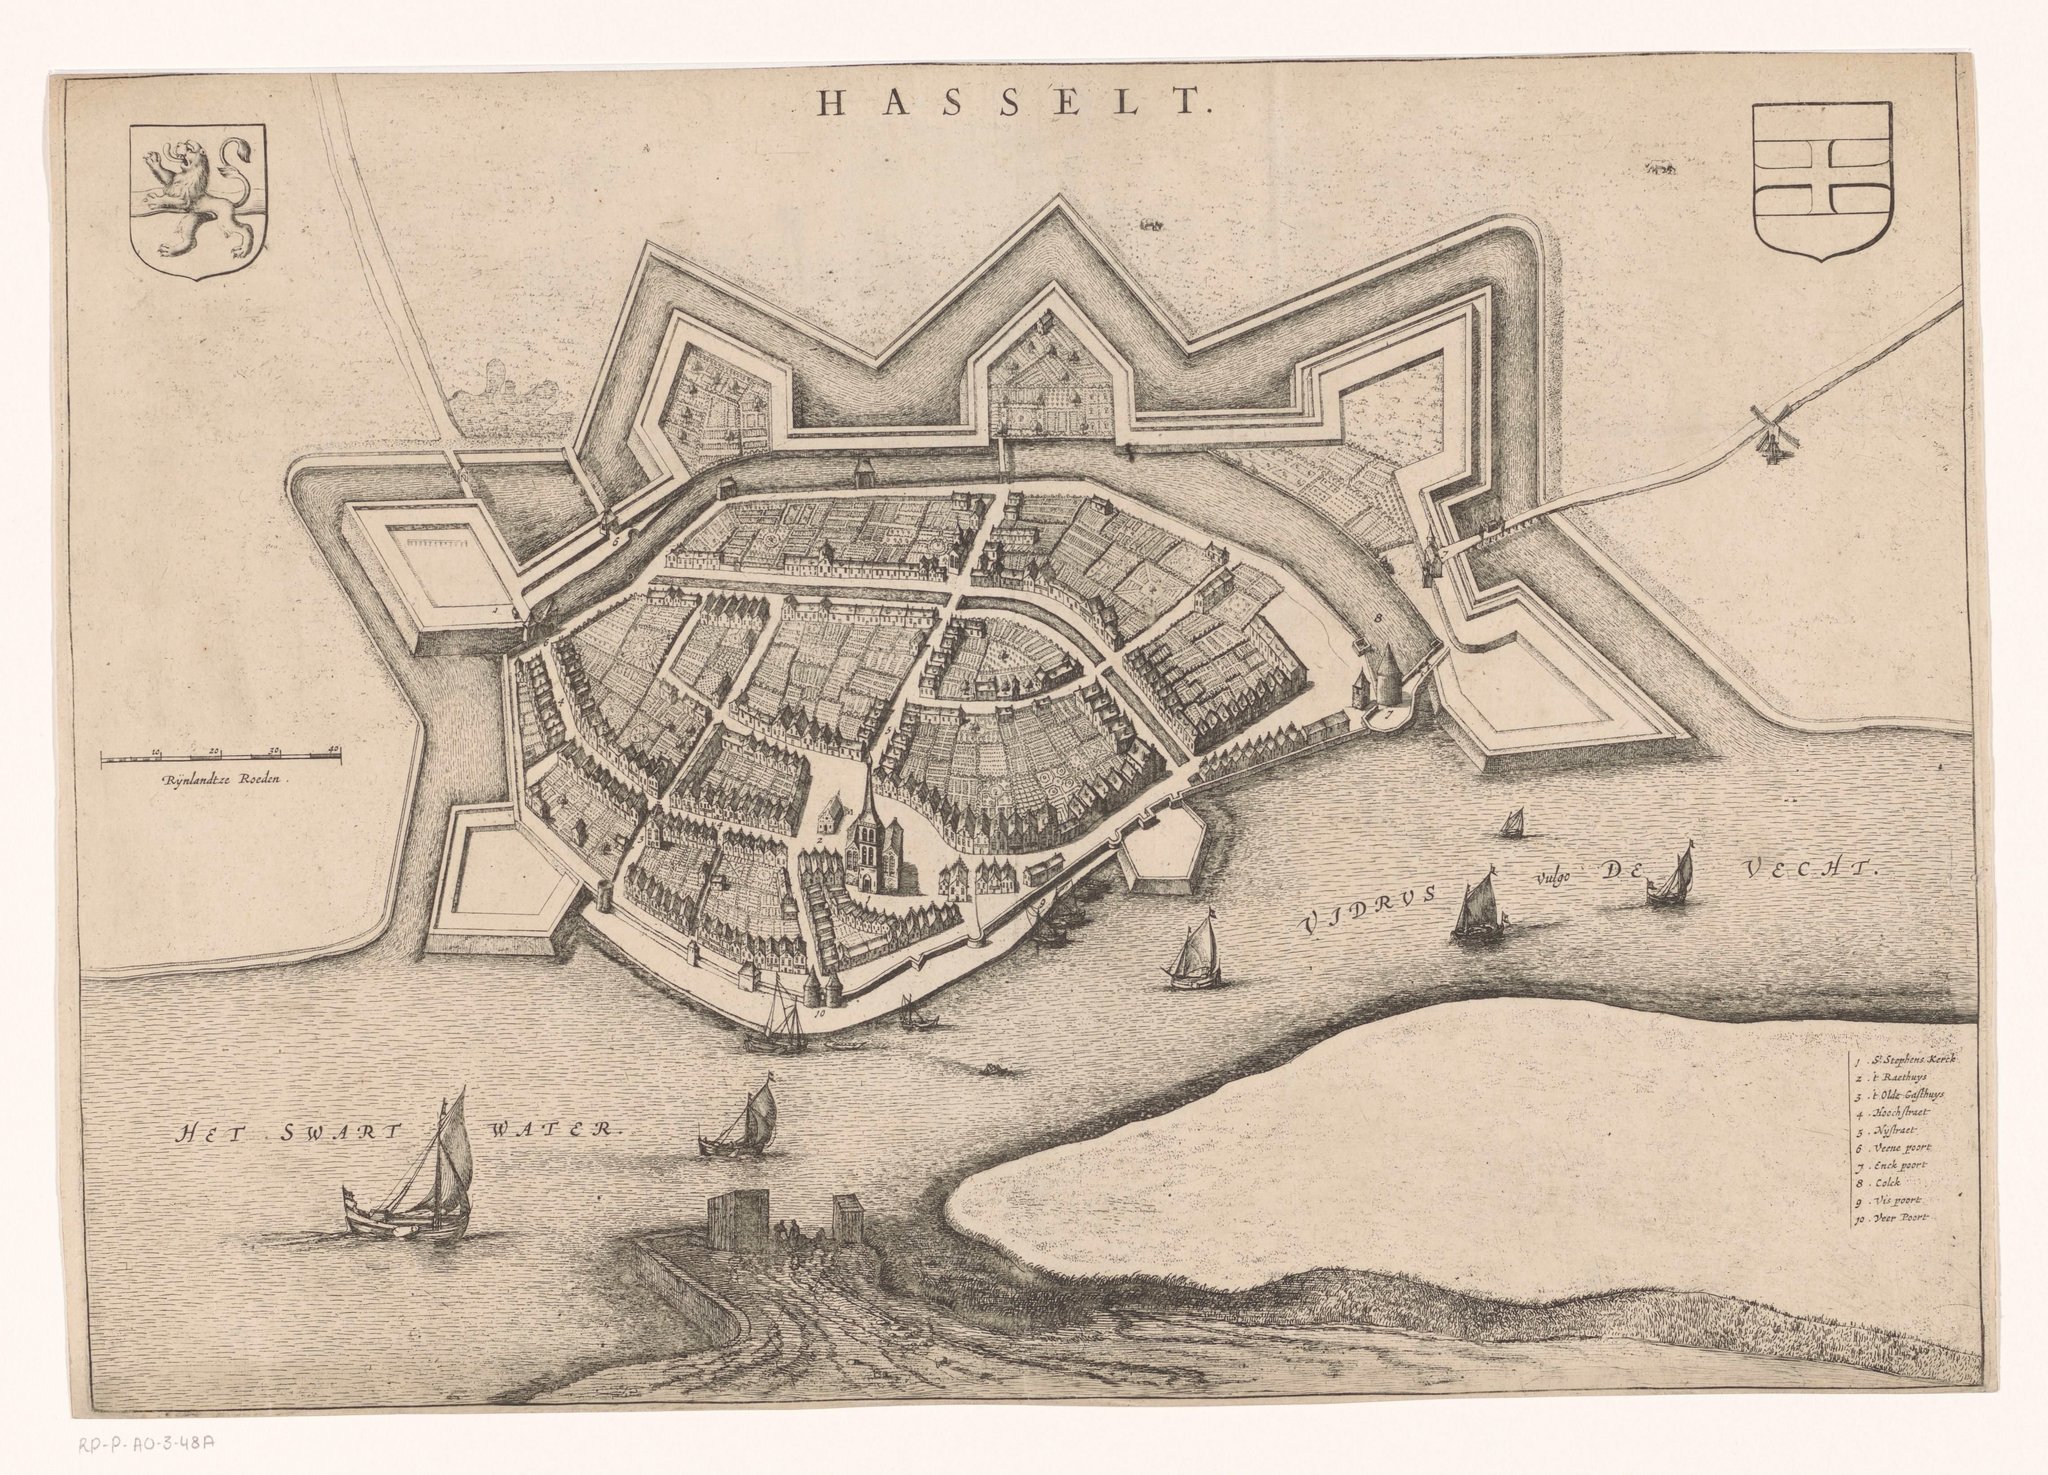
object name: print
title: Hasselt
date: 1649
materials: paper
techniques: engraving, etching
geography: amsterdam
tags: coat of arms (as symbol of the state, etc.), maps of cities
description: Plattegrond in vogelvluchtperspectief. Linksboven het wapen van Overijssel. Links in het midden een schaalstok: Rijnlandtze roeden. Rechtsboven het wapen van Hasselt, rechtsonder een legenda.